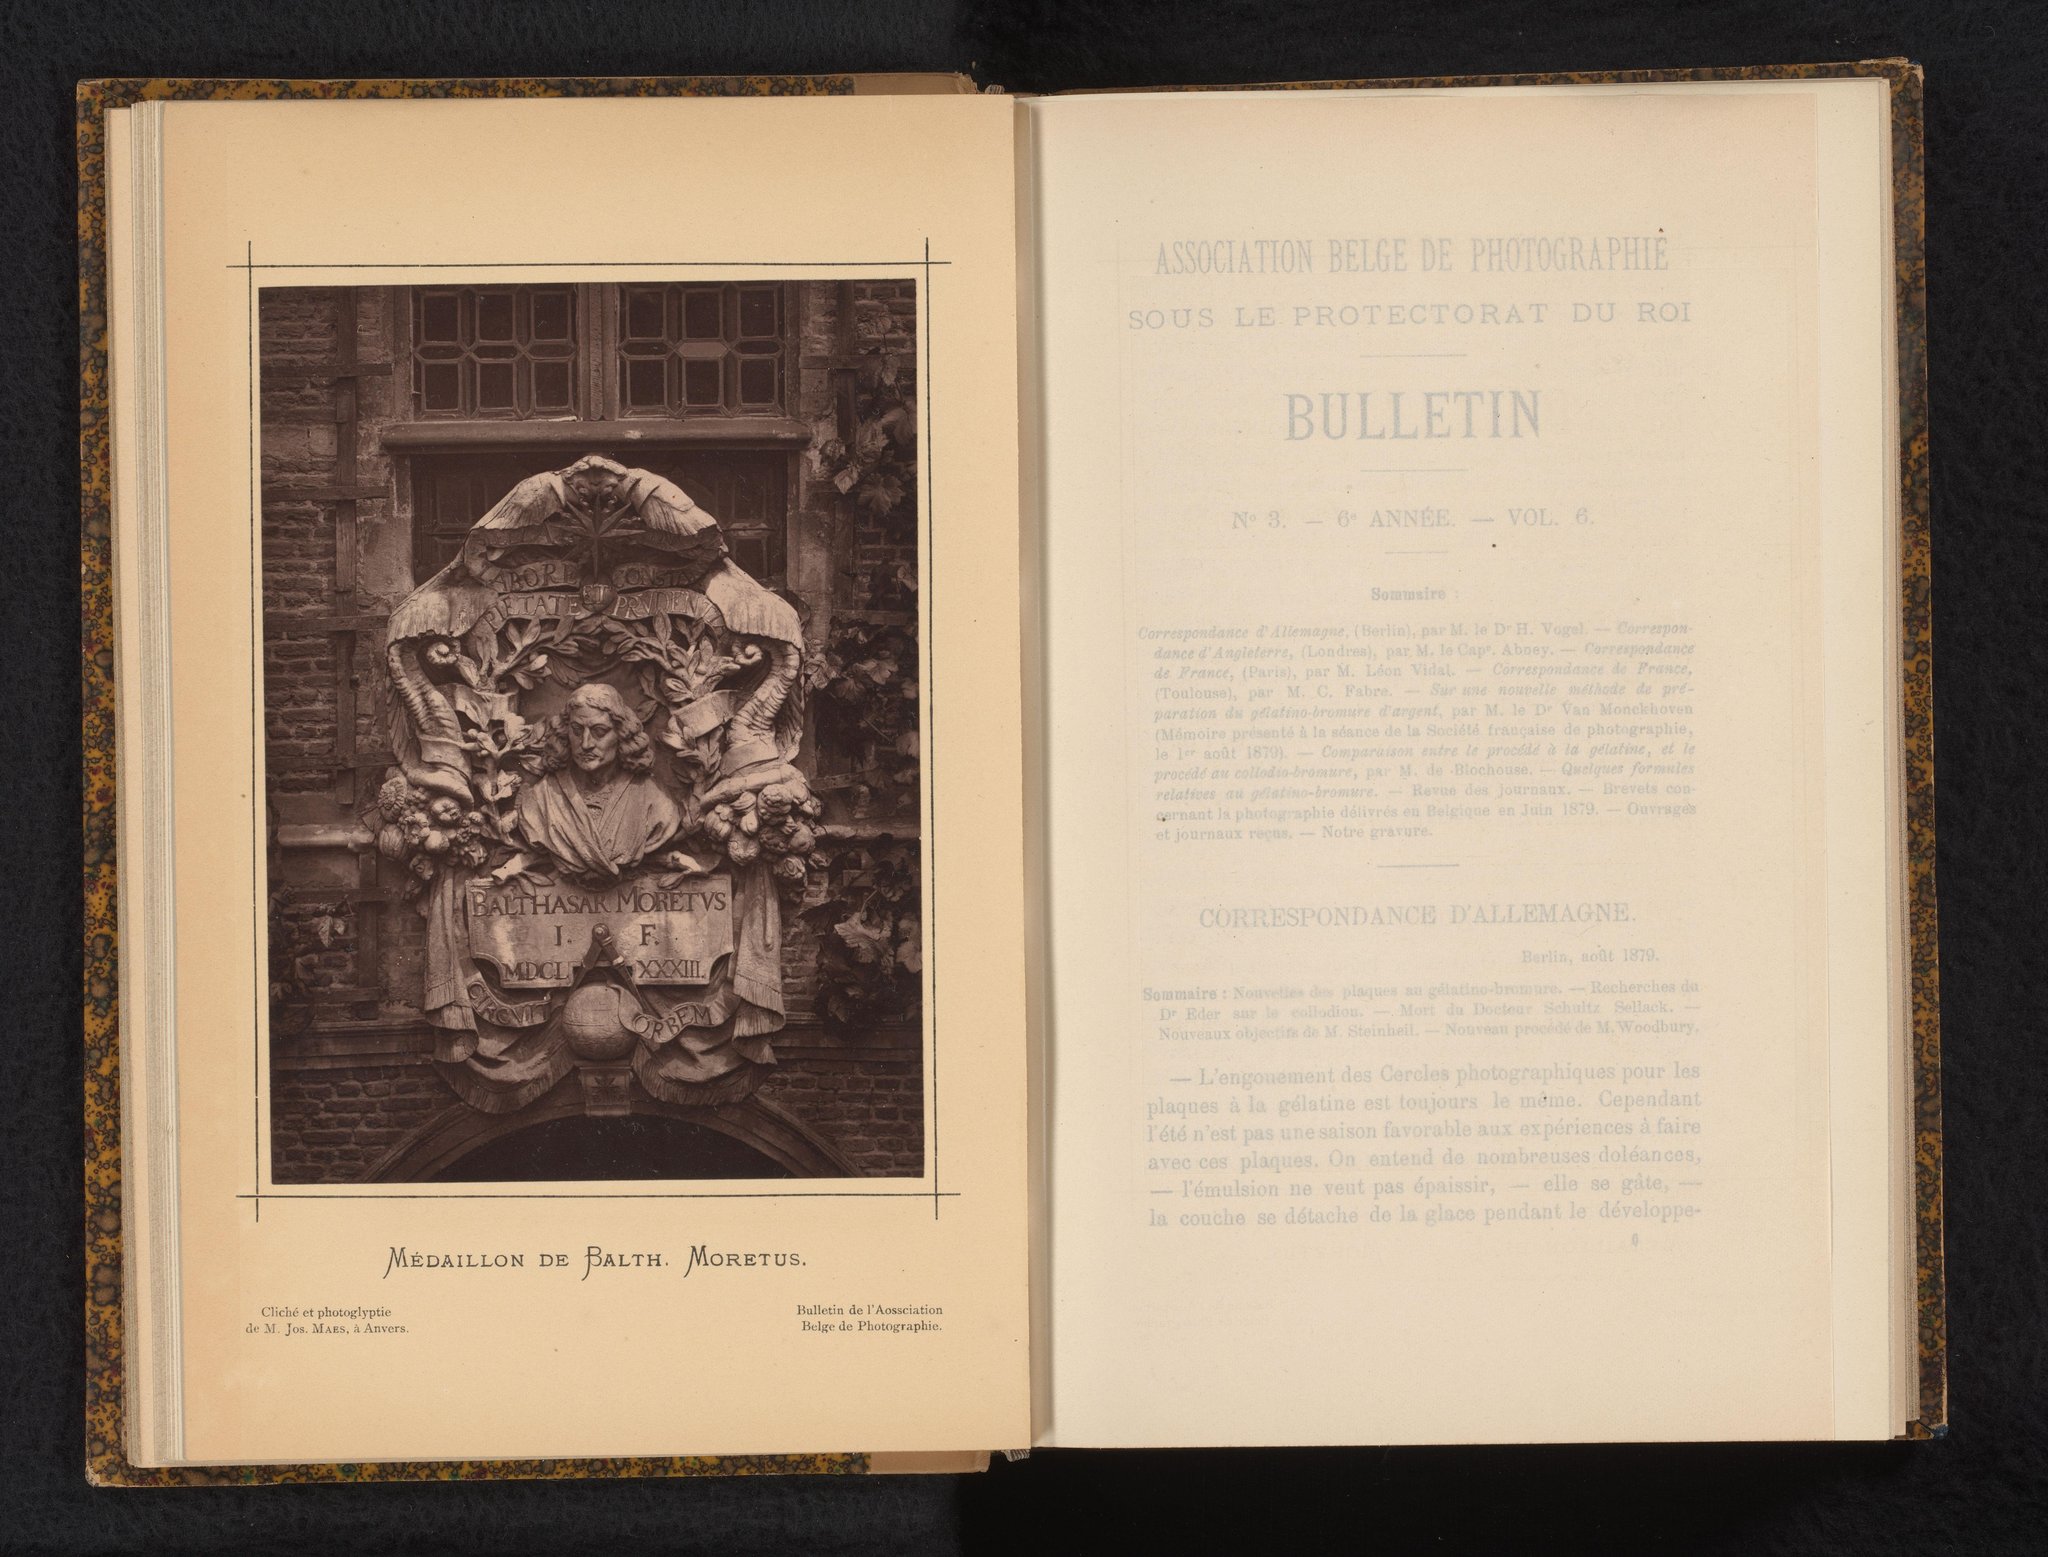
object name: page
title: Médaillon de Balth. Moretus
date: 1879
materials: cardboard, paper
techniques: woodburytype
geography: antwerp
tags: antwerp, printer, publisher, balthasar moretus (i), piece of sculpture, reproduction of a piece of sculpture